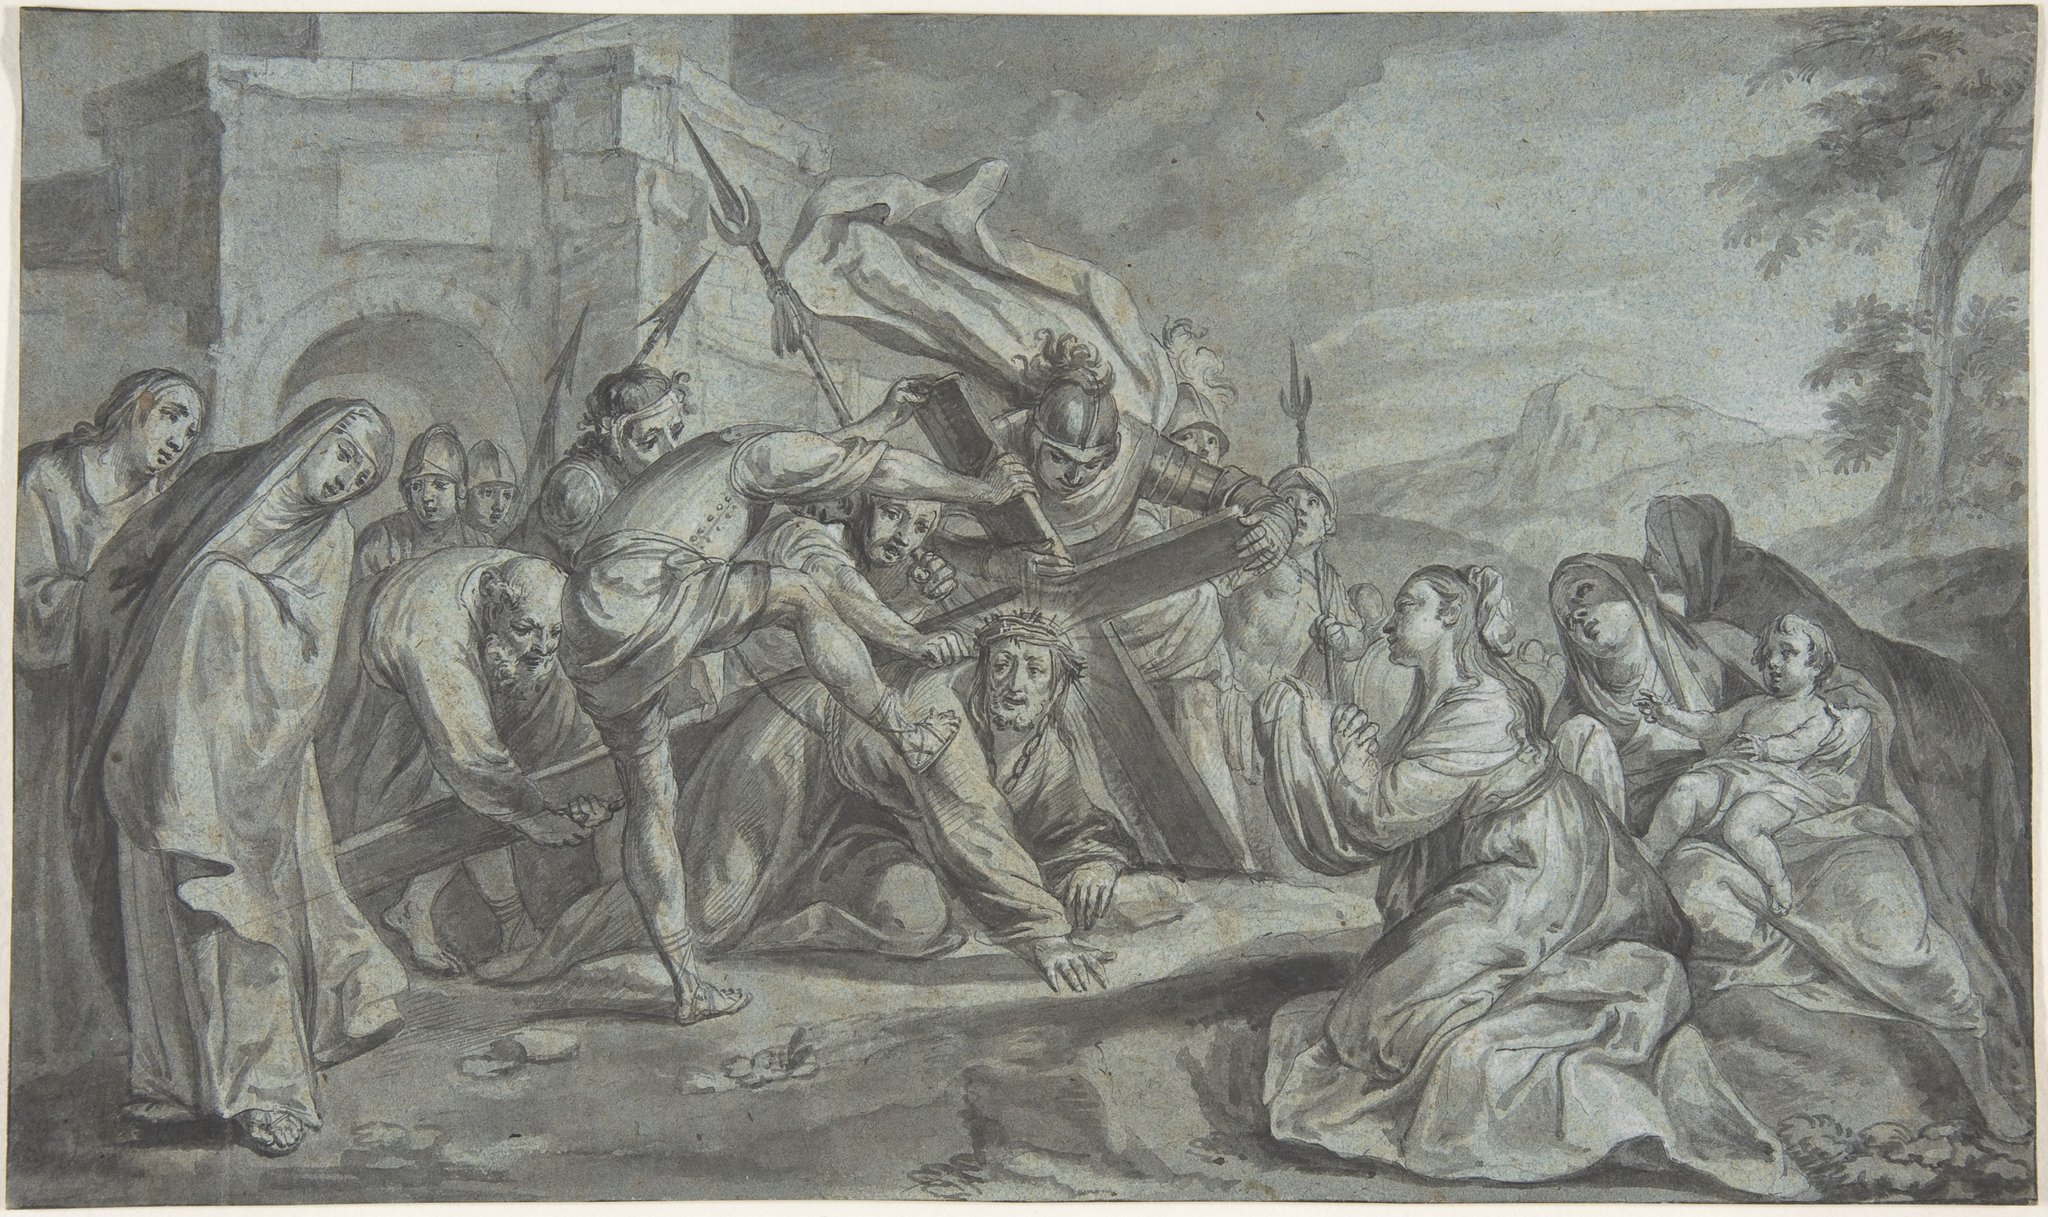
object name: drawing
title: Christ Carrying the Cross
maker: johann wolfgang baumgartner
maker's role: artist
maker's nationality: german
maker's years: 1712-1761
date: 1720-1761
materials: graphite, ink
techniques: brush, pen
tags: men,women,christ,cross